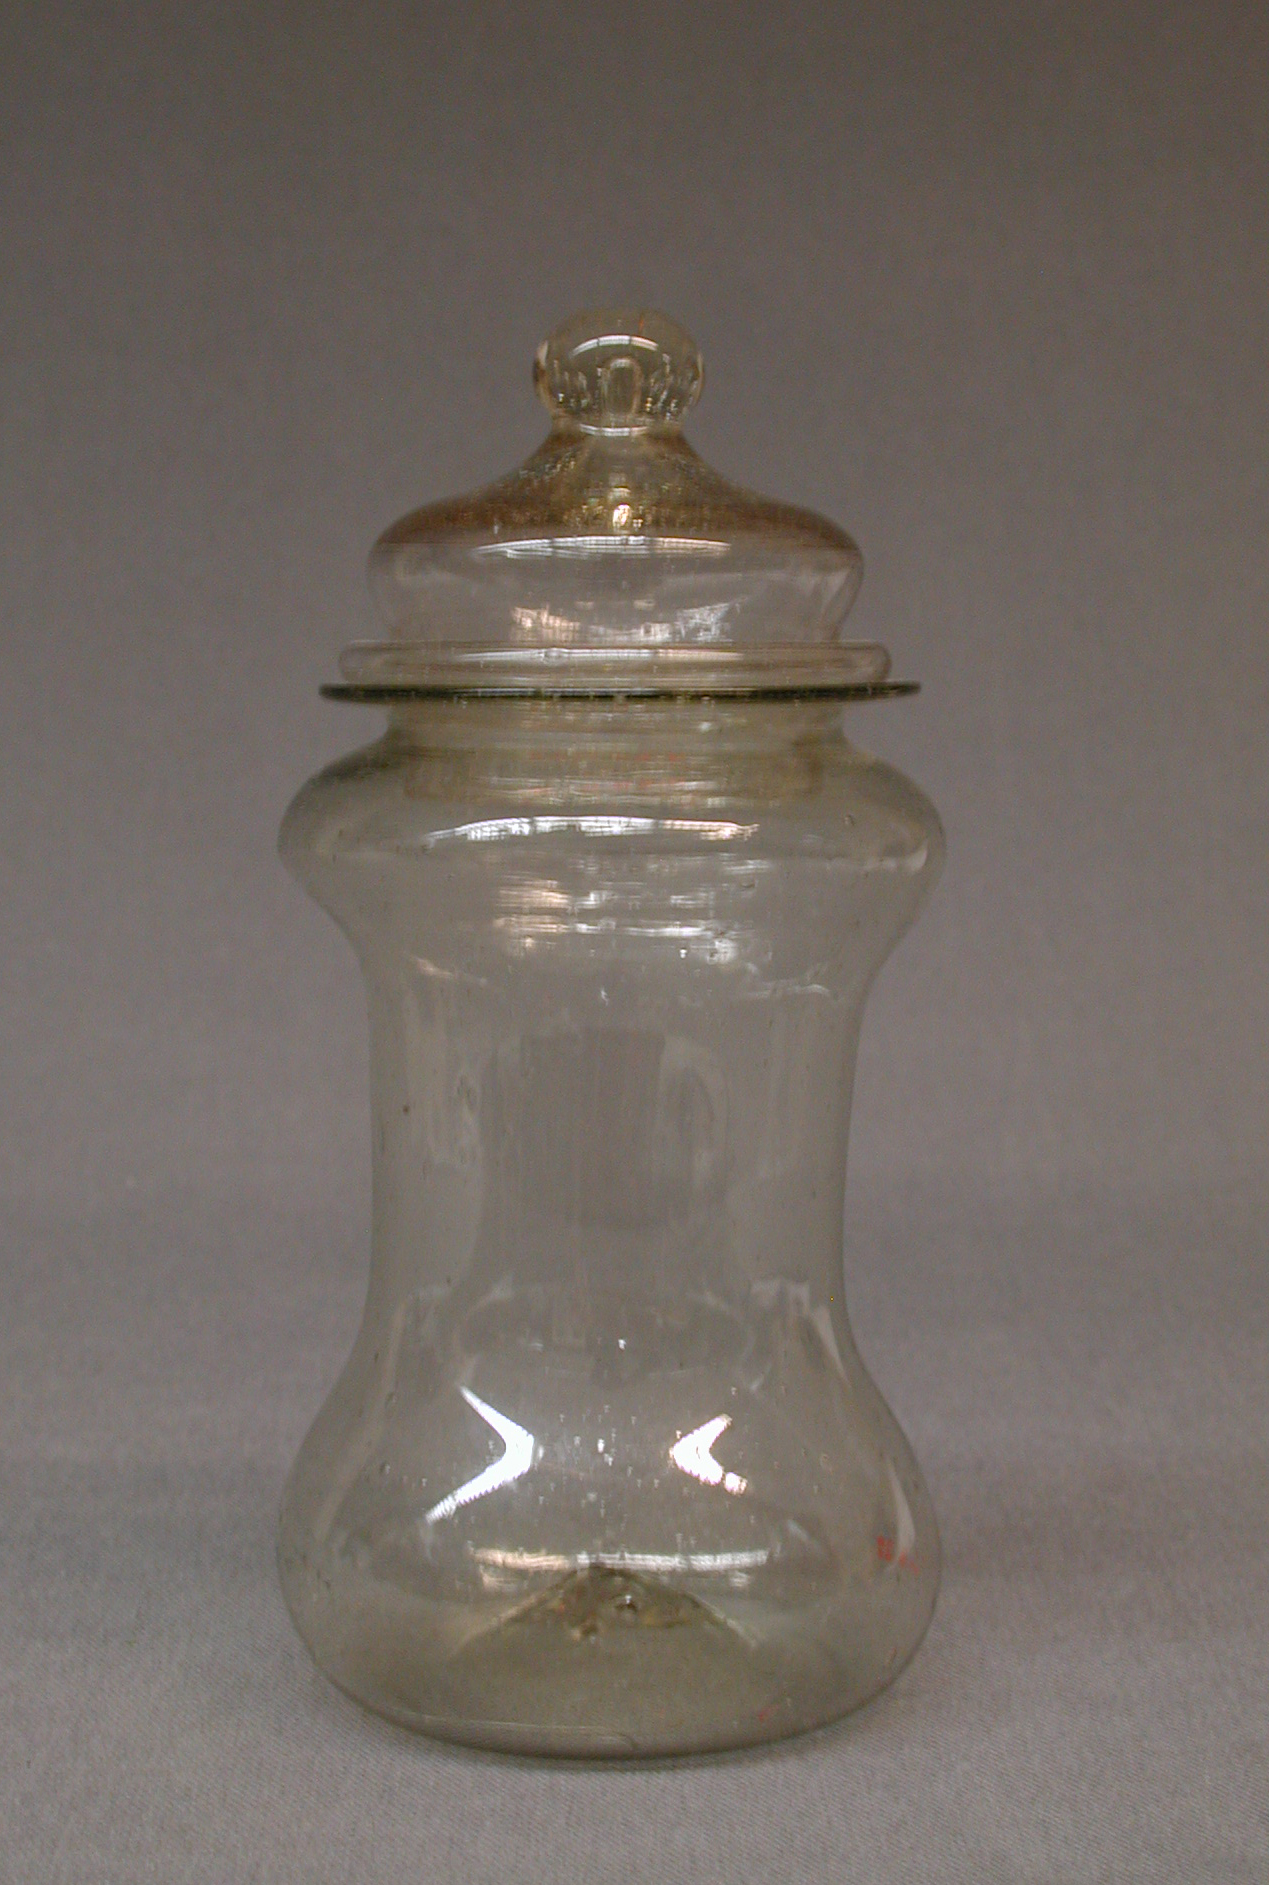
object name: pharmacy jar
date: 1701-1800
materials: glass